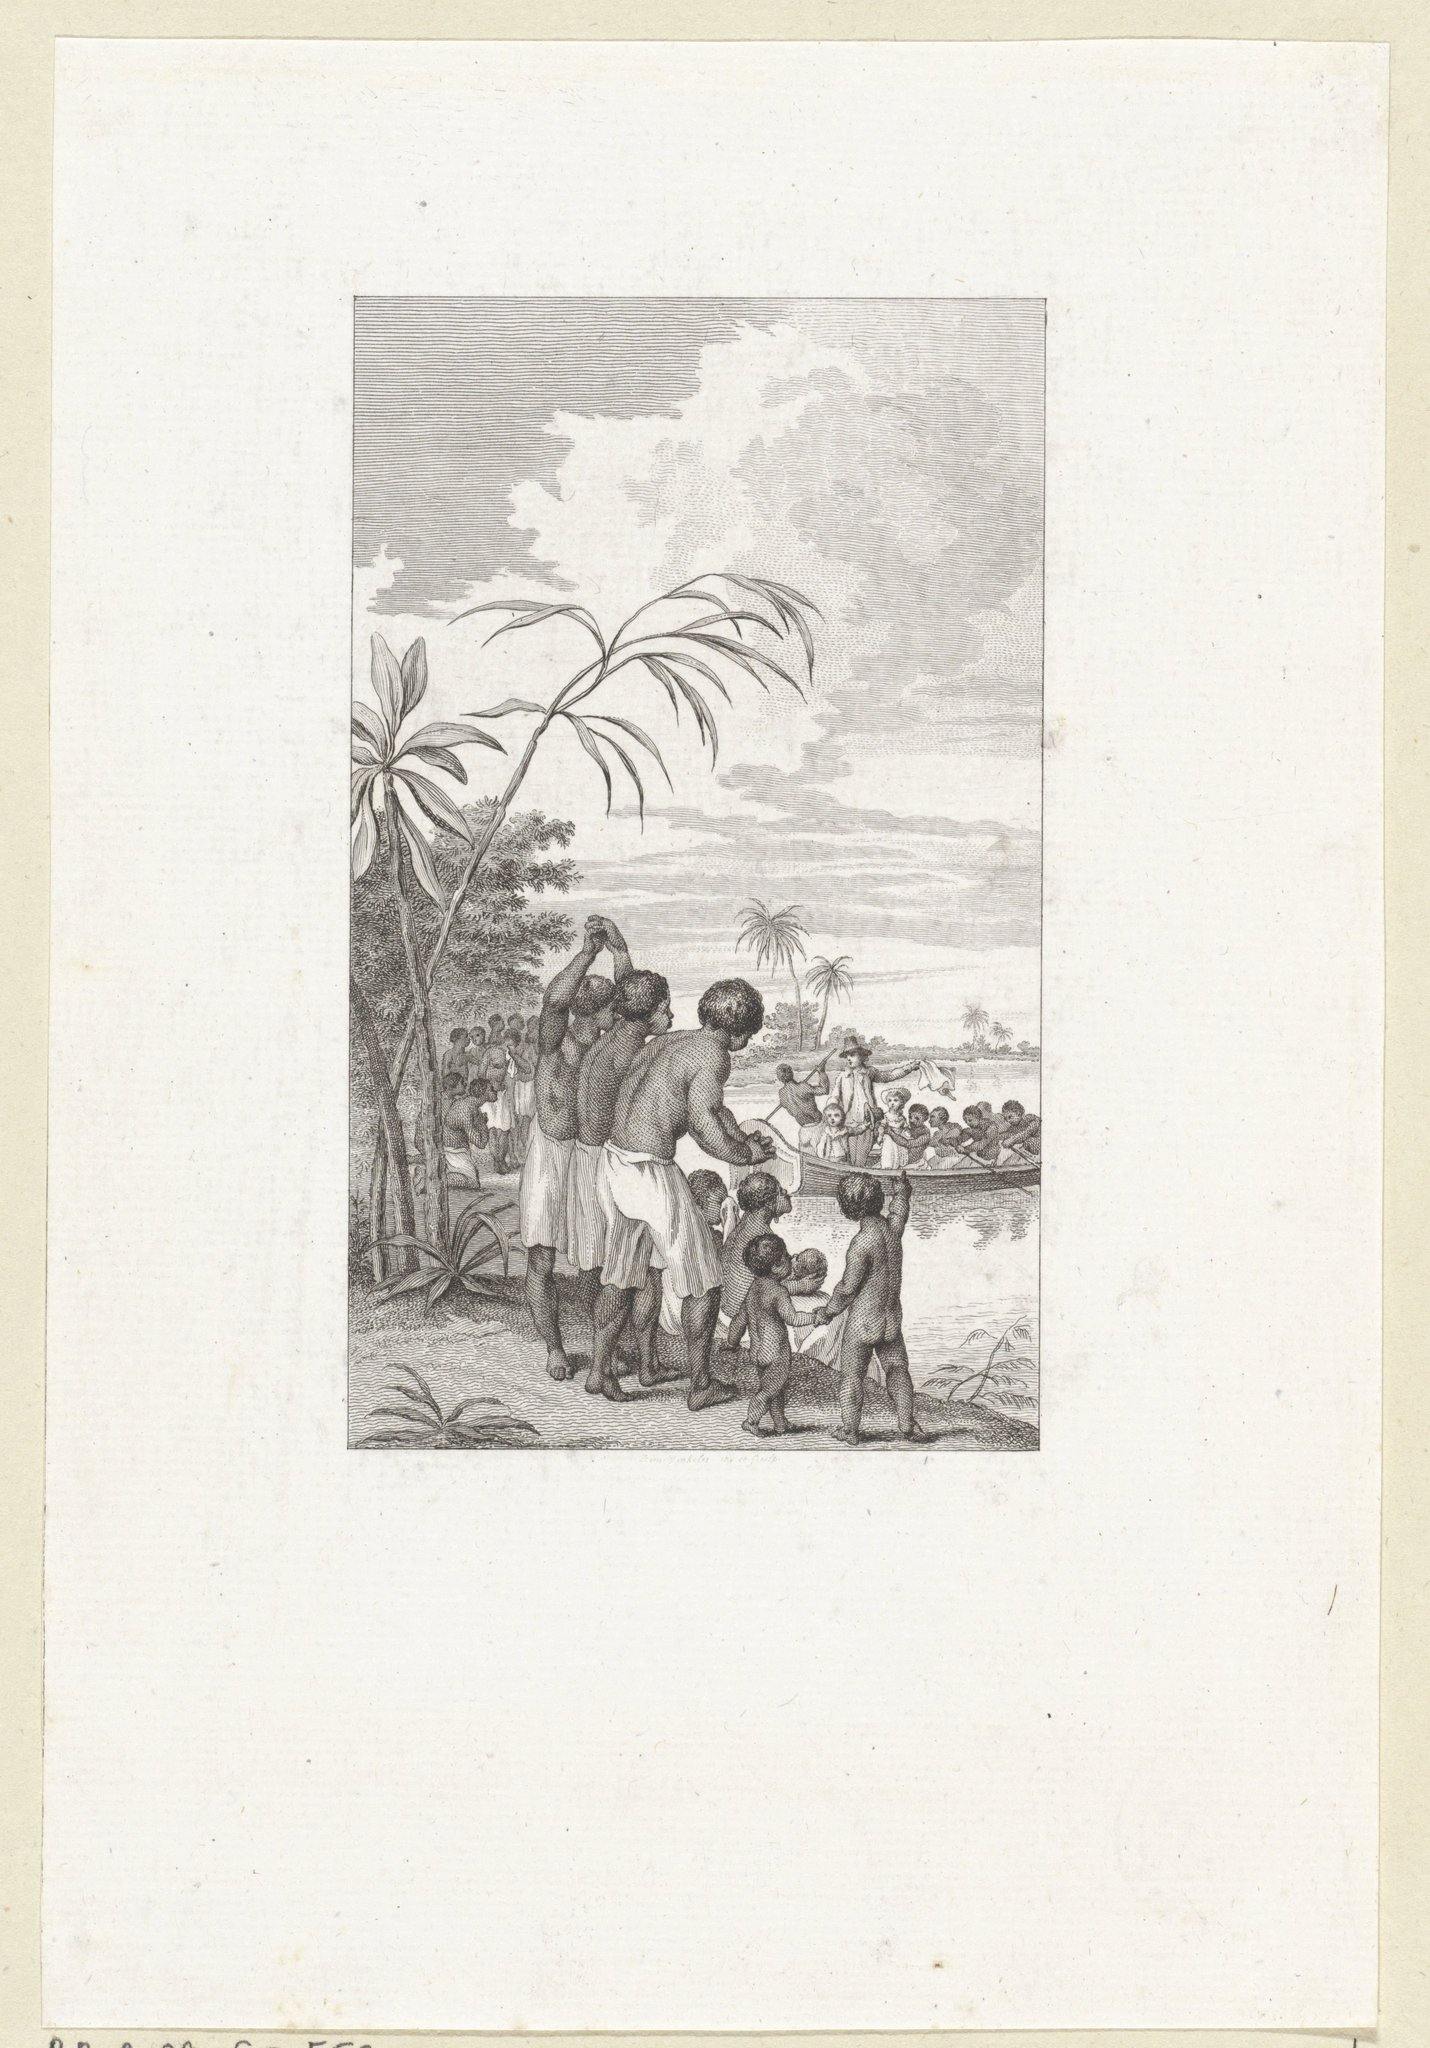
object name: print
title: Reinhart neemt afscheid van enkele Guyanezen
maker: reinier vinkeles (i)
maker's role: draughtsman, print maker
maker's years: 1741-1816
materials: paper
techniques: engraving, etching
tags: landscapes in tropical and sub-tropical regions, rowing-boat, canoe, etc., slavery; serfs and enslaved persons, human races, peoples and nationalities (other than prehistoric or extinct), waving farewell ~ departure on a journey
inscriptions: collector's mark: Lugt 240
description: Latere staat van prent gebruikt in: Post, Elisabeth Maria. Reinhart, of Natuur en Godsdienst. 3 dln. 1e druk. Amsterdam: Johannes Allart, 1791-1792, dl. 3 (1792), p. 339. En in: Post, Elisabeth Maria. Reinhart, of Natuur en Godsdienst. 3 dln. 2e druk. Amsterdam: Johannes Allart, 1798-1802, dl. 3 (1802), p. 339.